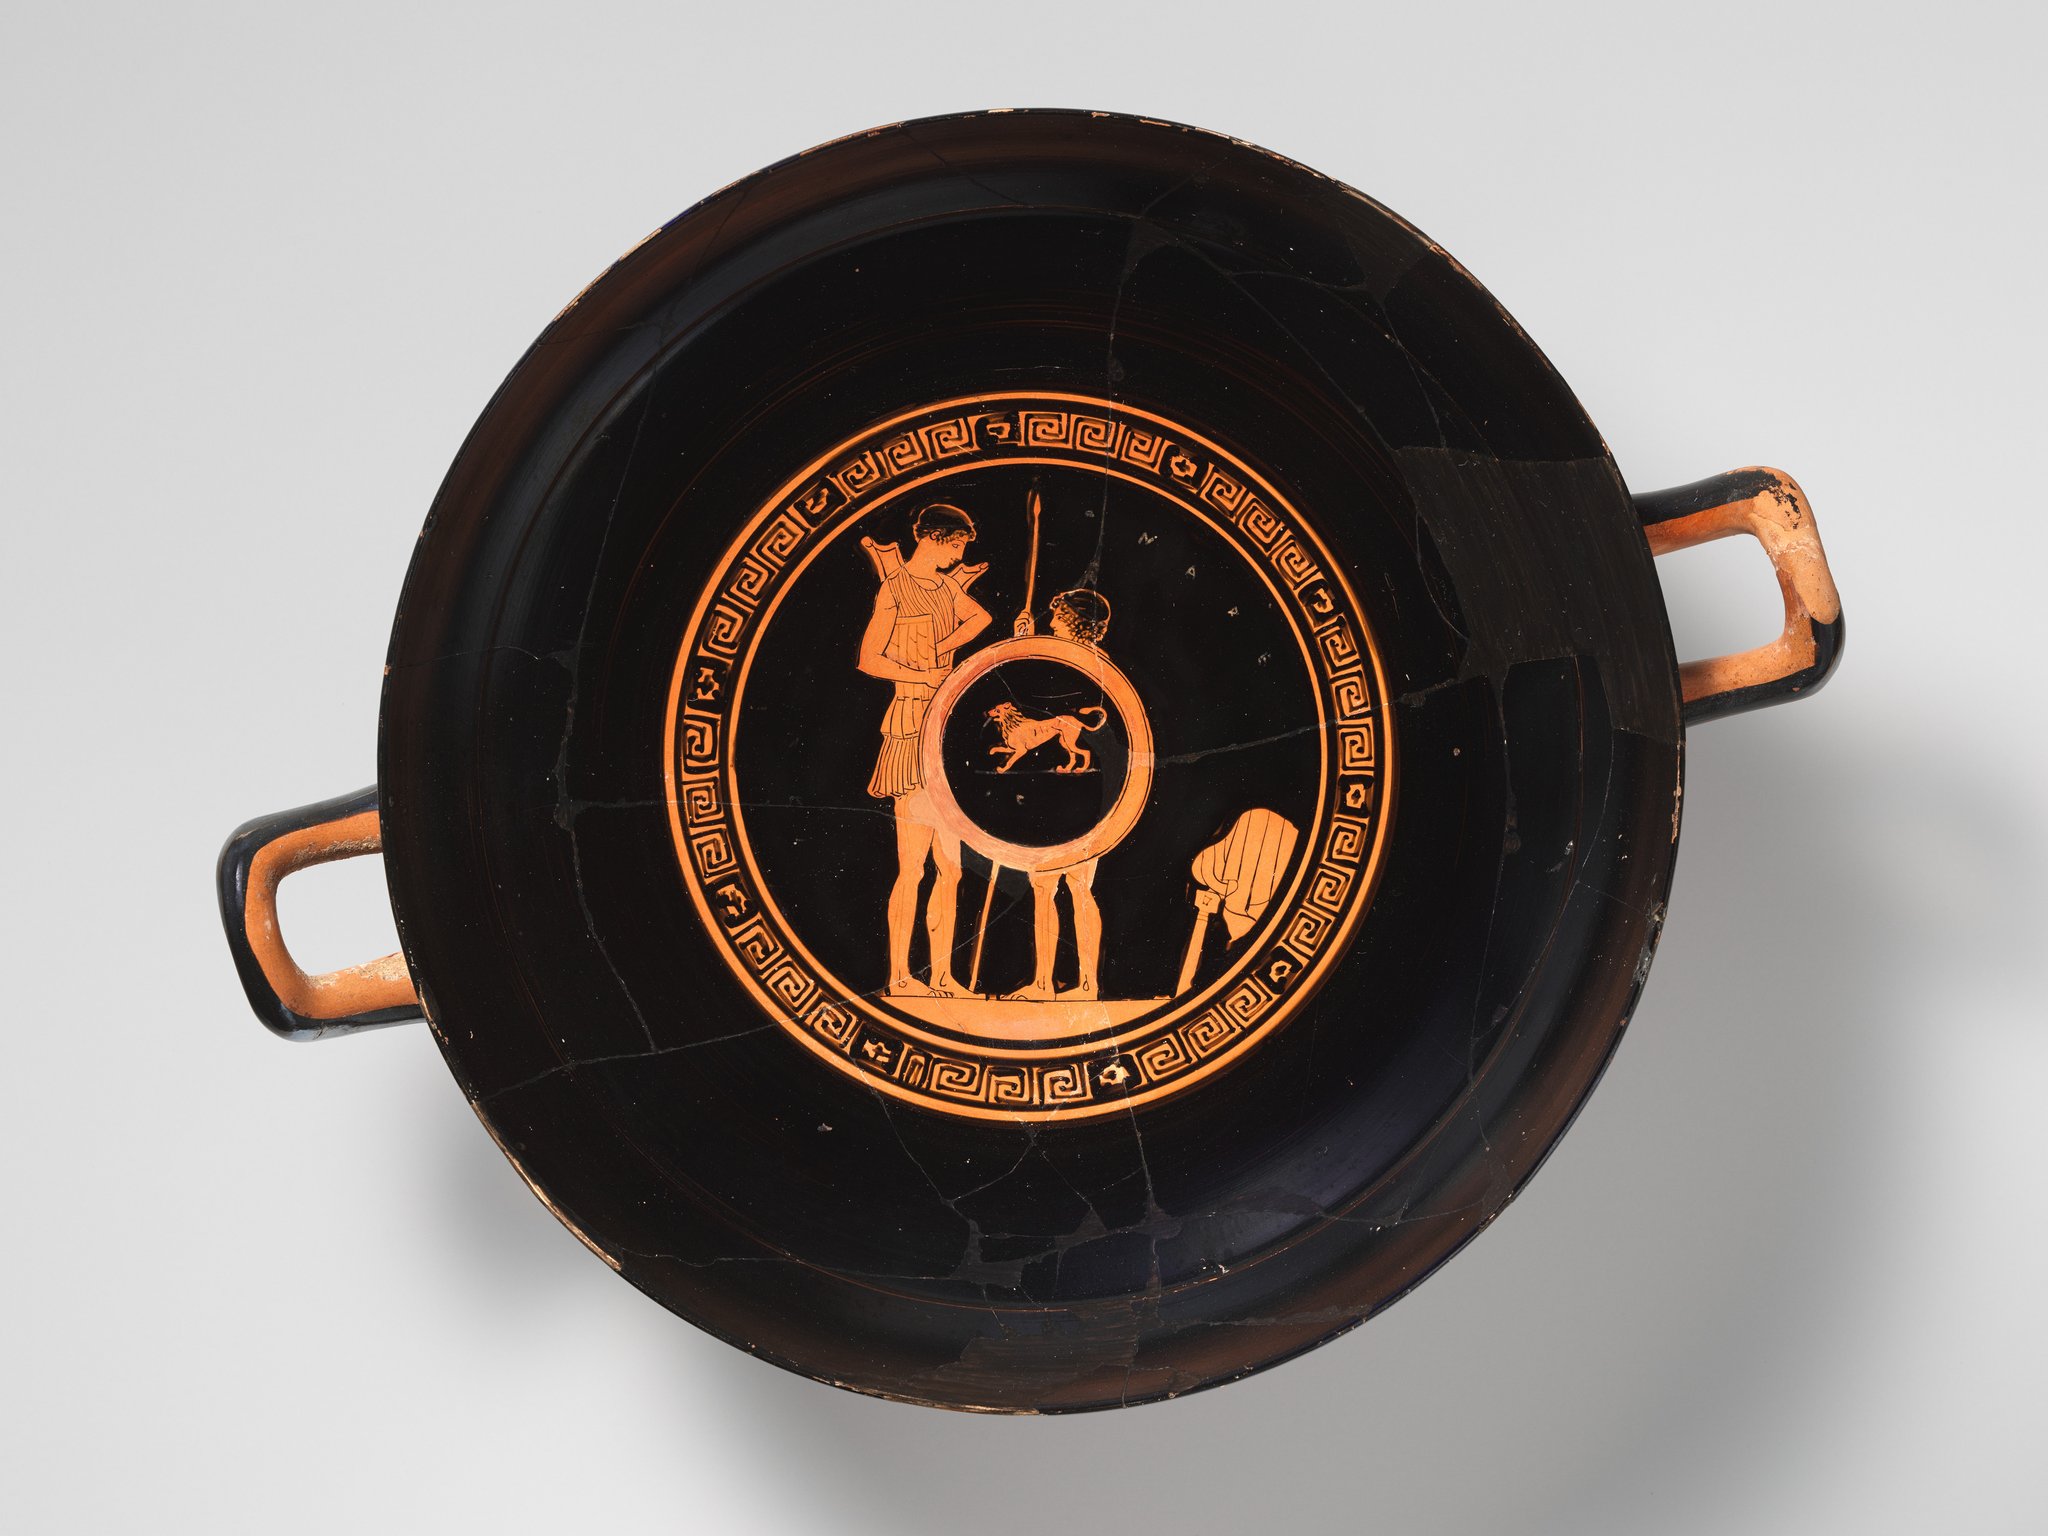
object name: kylix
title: Terracotta kylix (drinking cup)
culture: greek, attic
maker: lyandros painter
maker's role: artist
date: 450 BCE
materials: terracotta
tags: shields,spears,men,lions